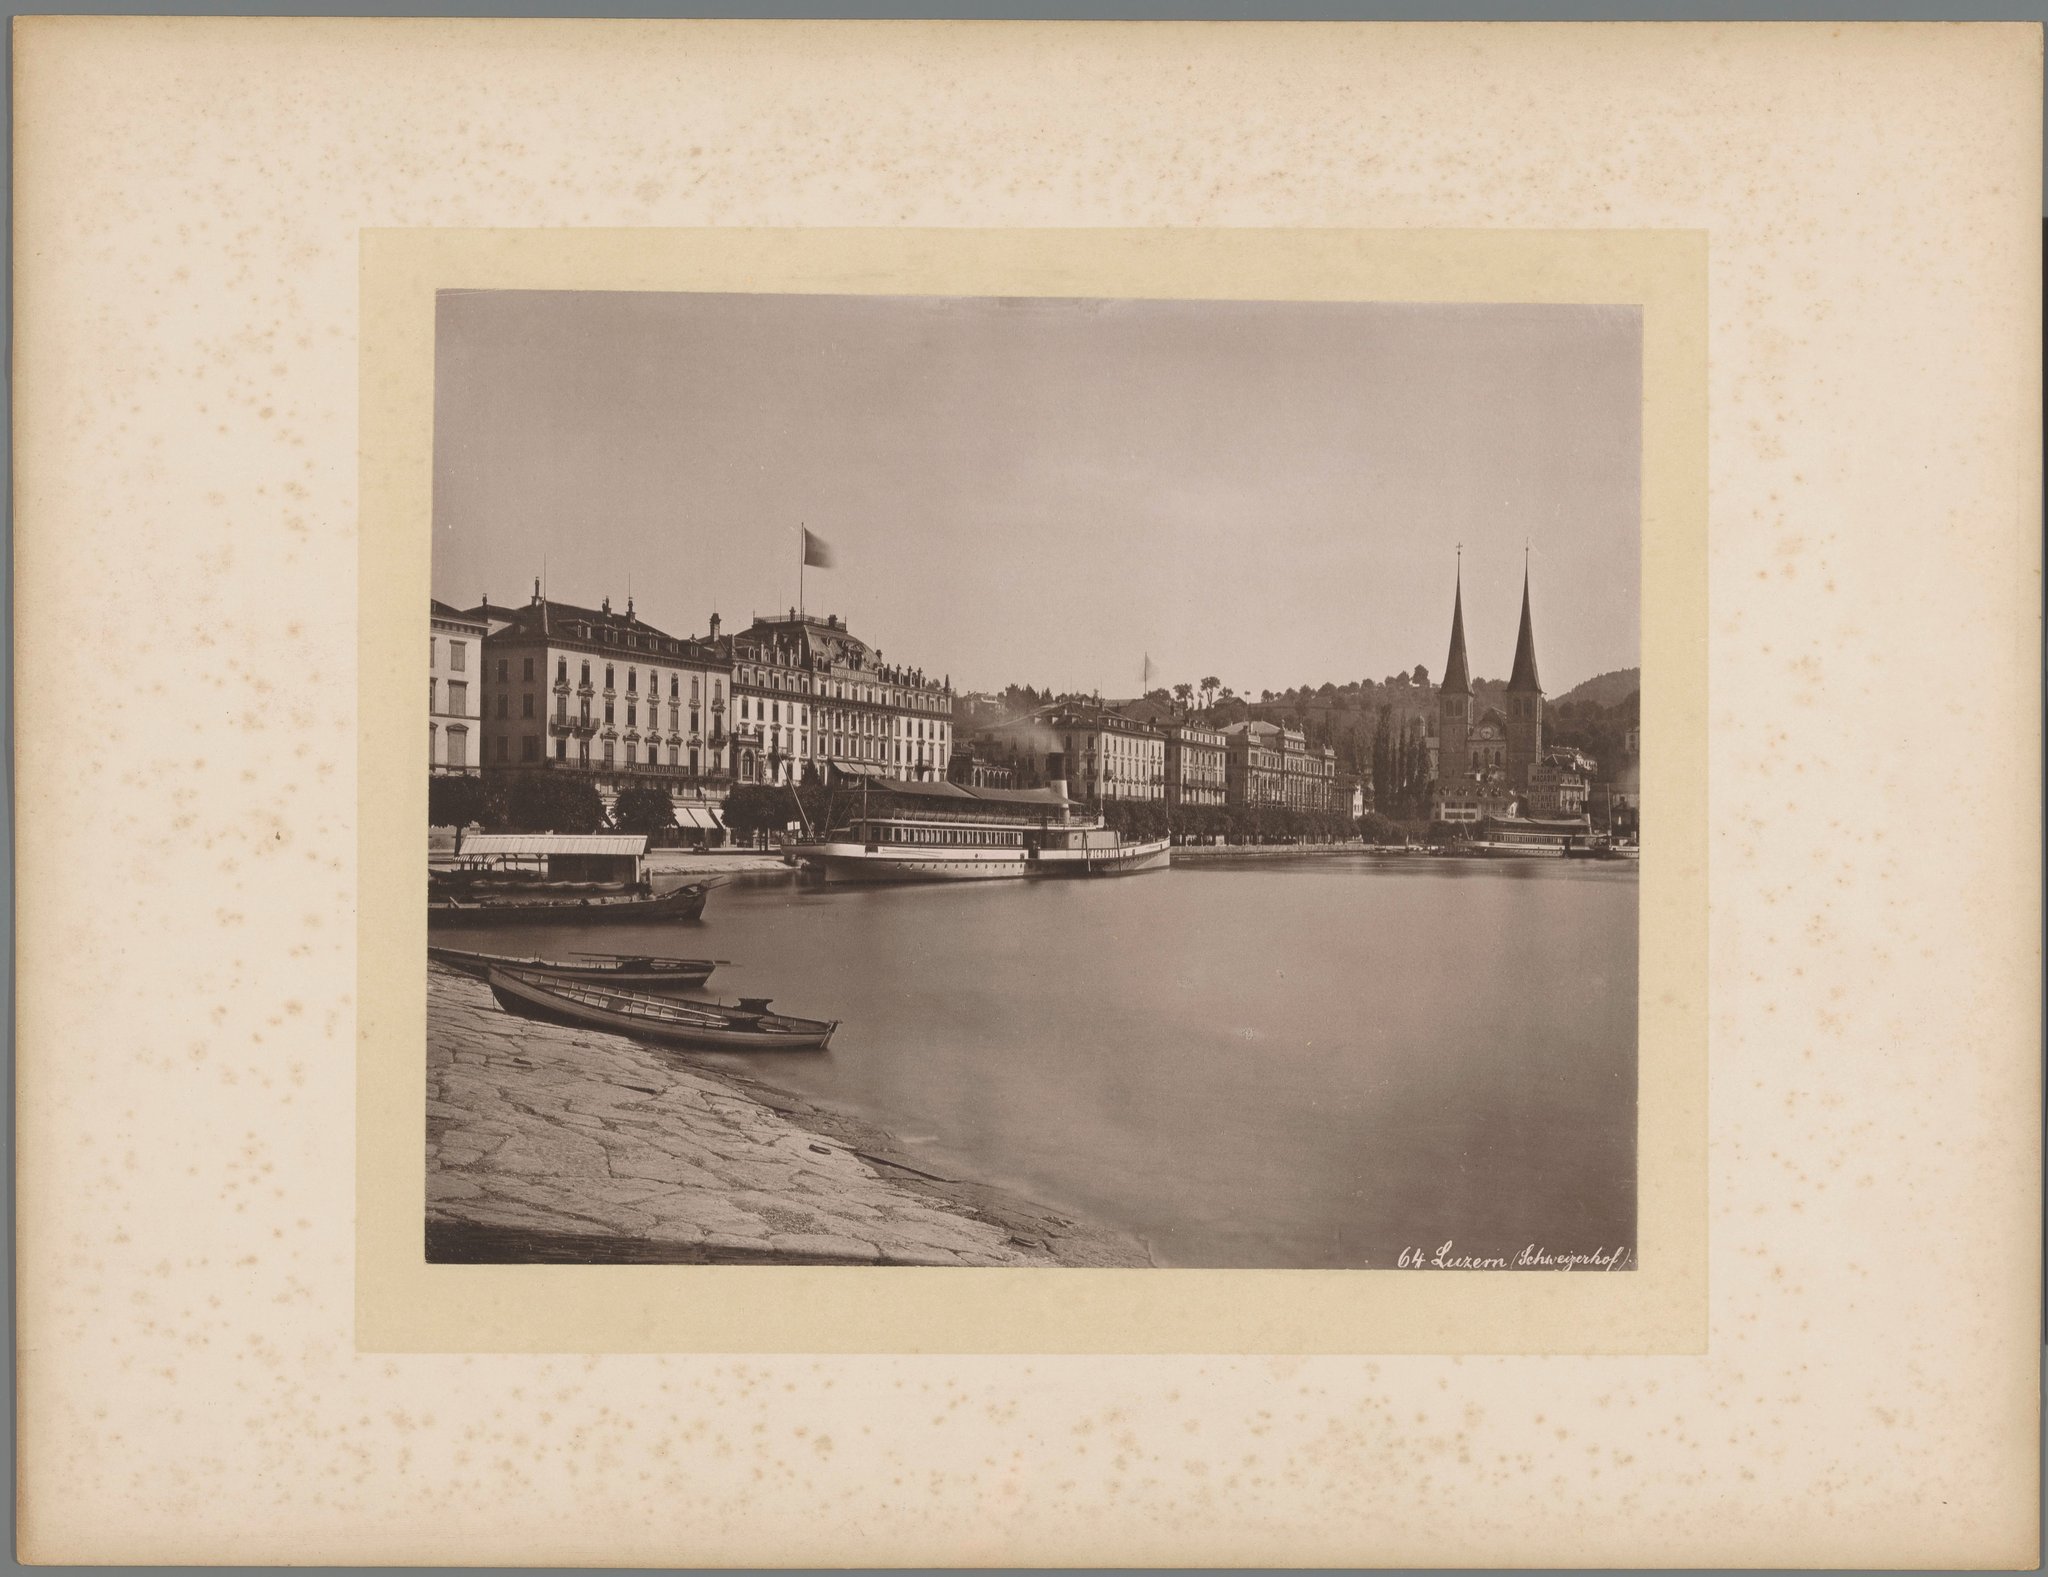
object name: photomechanical print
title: Luzern (Schweizerhof)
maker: Anonymous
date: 1870-1930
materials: cardboard, paper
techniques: photograph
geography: lucerne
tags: city-view in general; 'veduta'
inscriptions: number: ‘64’